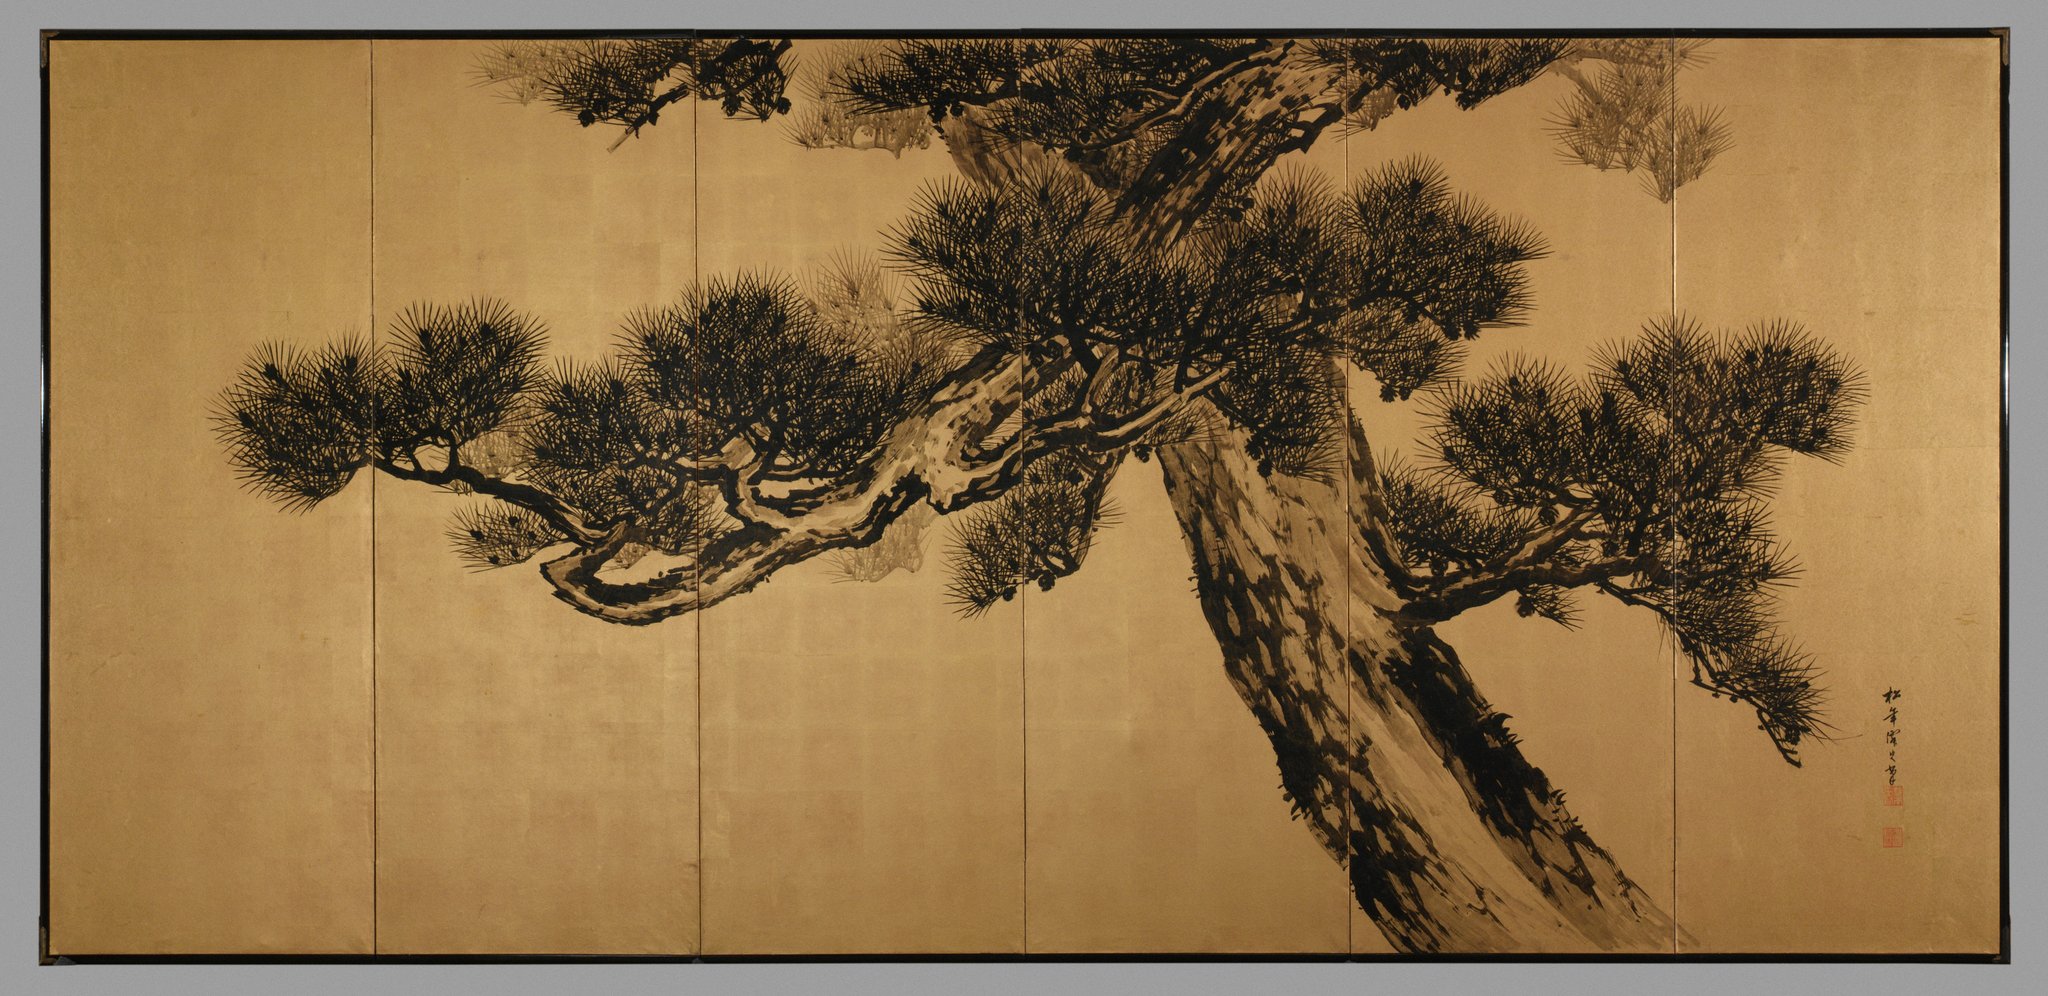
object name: screen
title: Aged Pines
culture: japanese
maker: suzuki shōnen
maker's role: artist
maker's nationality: japanese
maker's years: 1849-1918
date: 1867-1900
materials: gold leaf, ink, panel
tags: trees